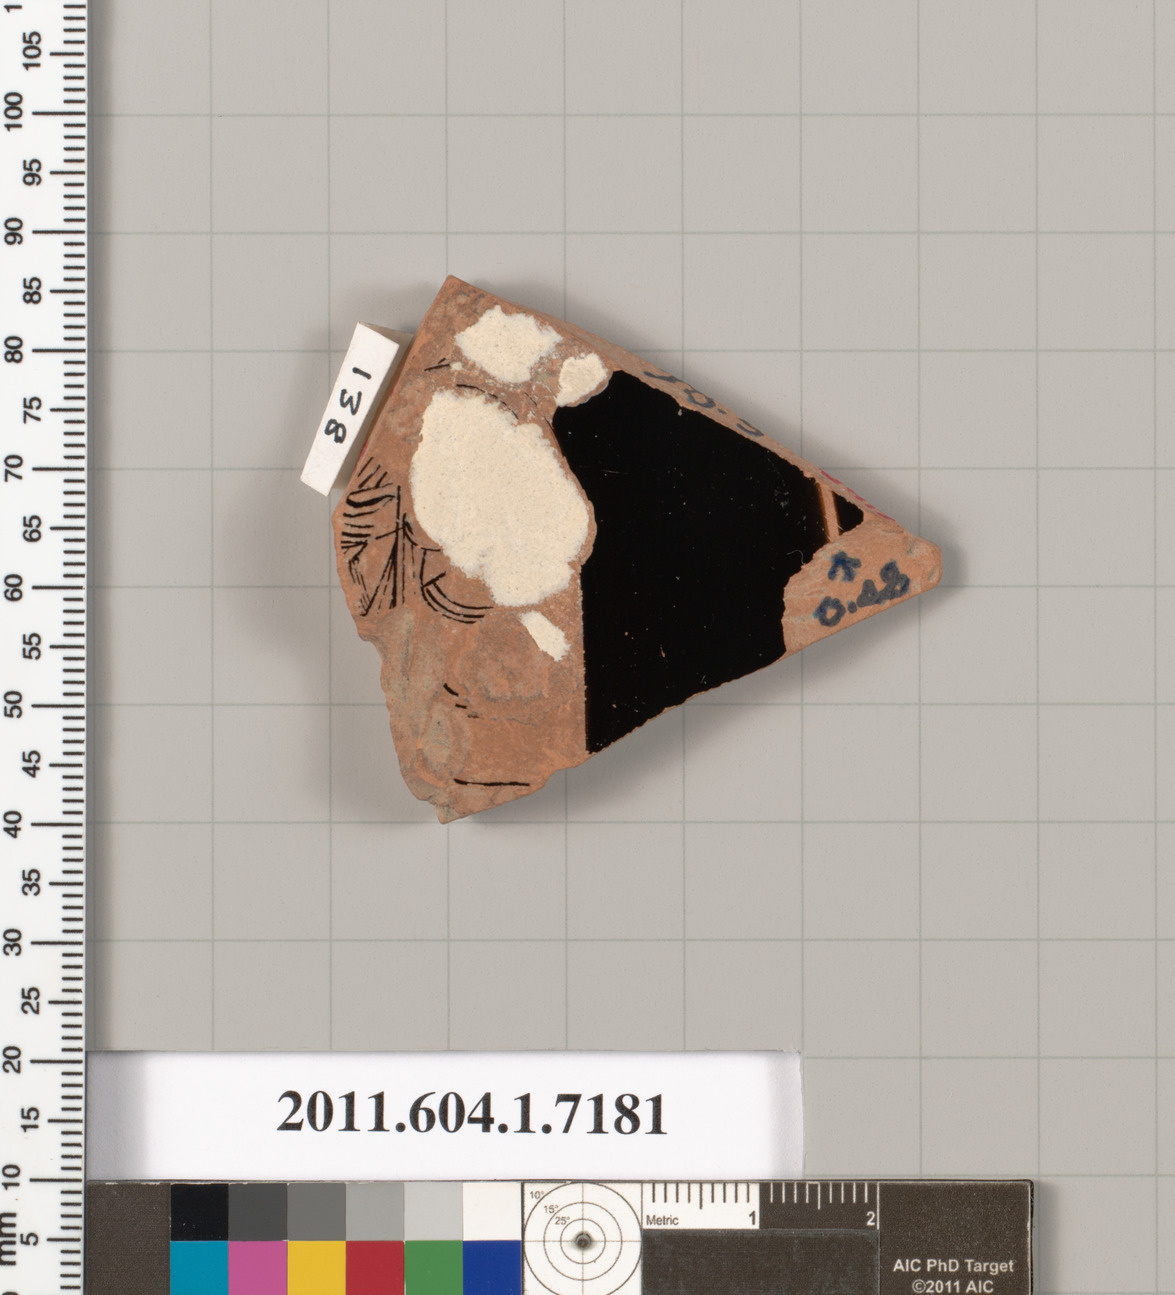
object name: kylix fragment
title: Terracotta fragment of a kylix (drinking cup)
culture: greek, attic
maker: makron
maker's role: artist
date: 500-480 BCE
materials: terracotta